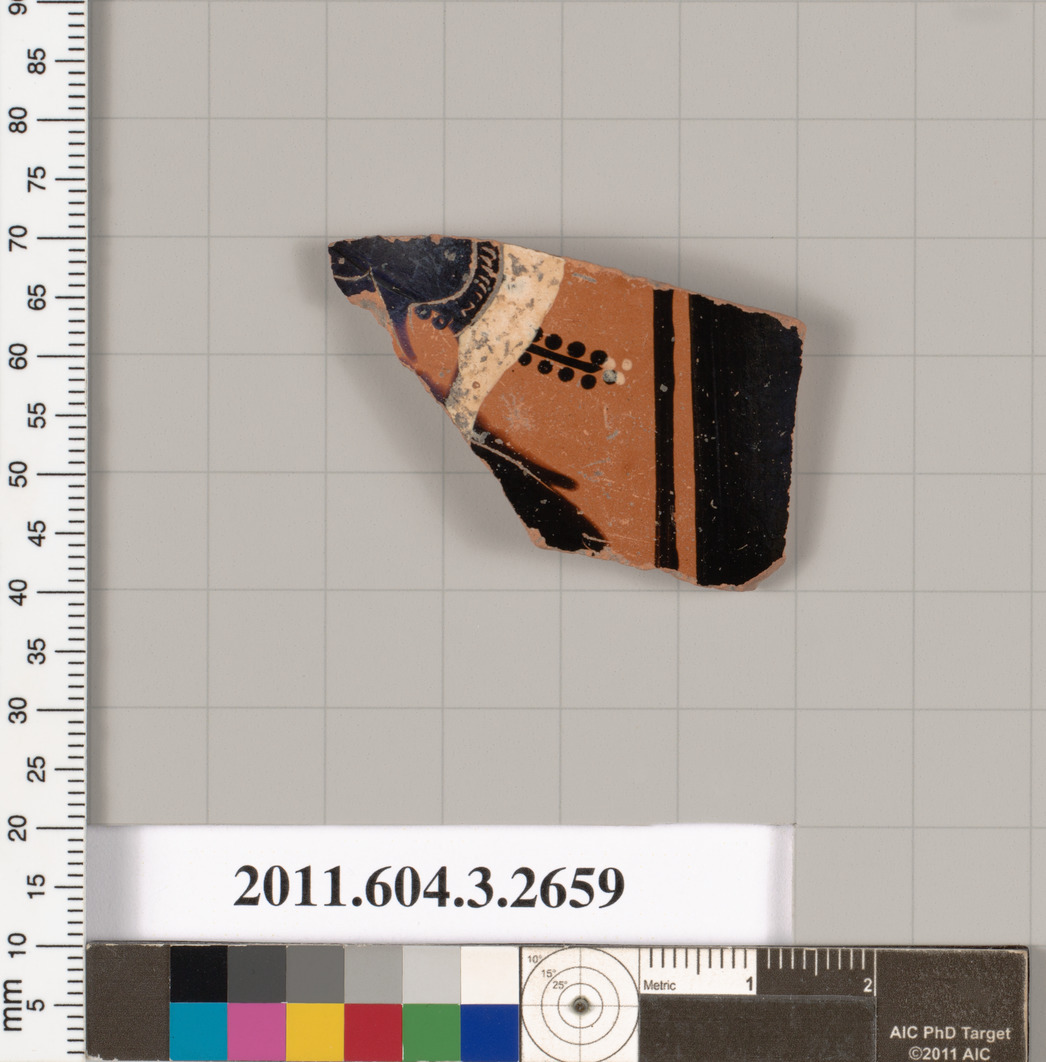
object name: olpe fragment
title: Terracotta fragment of an olpe (jug)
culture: greek, attic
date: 530-510 BCE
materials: terracotta